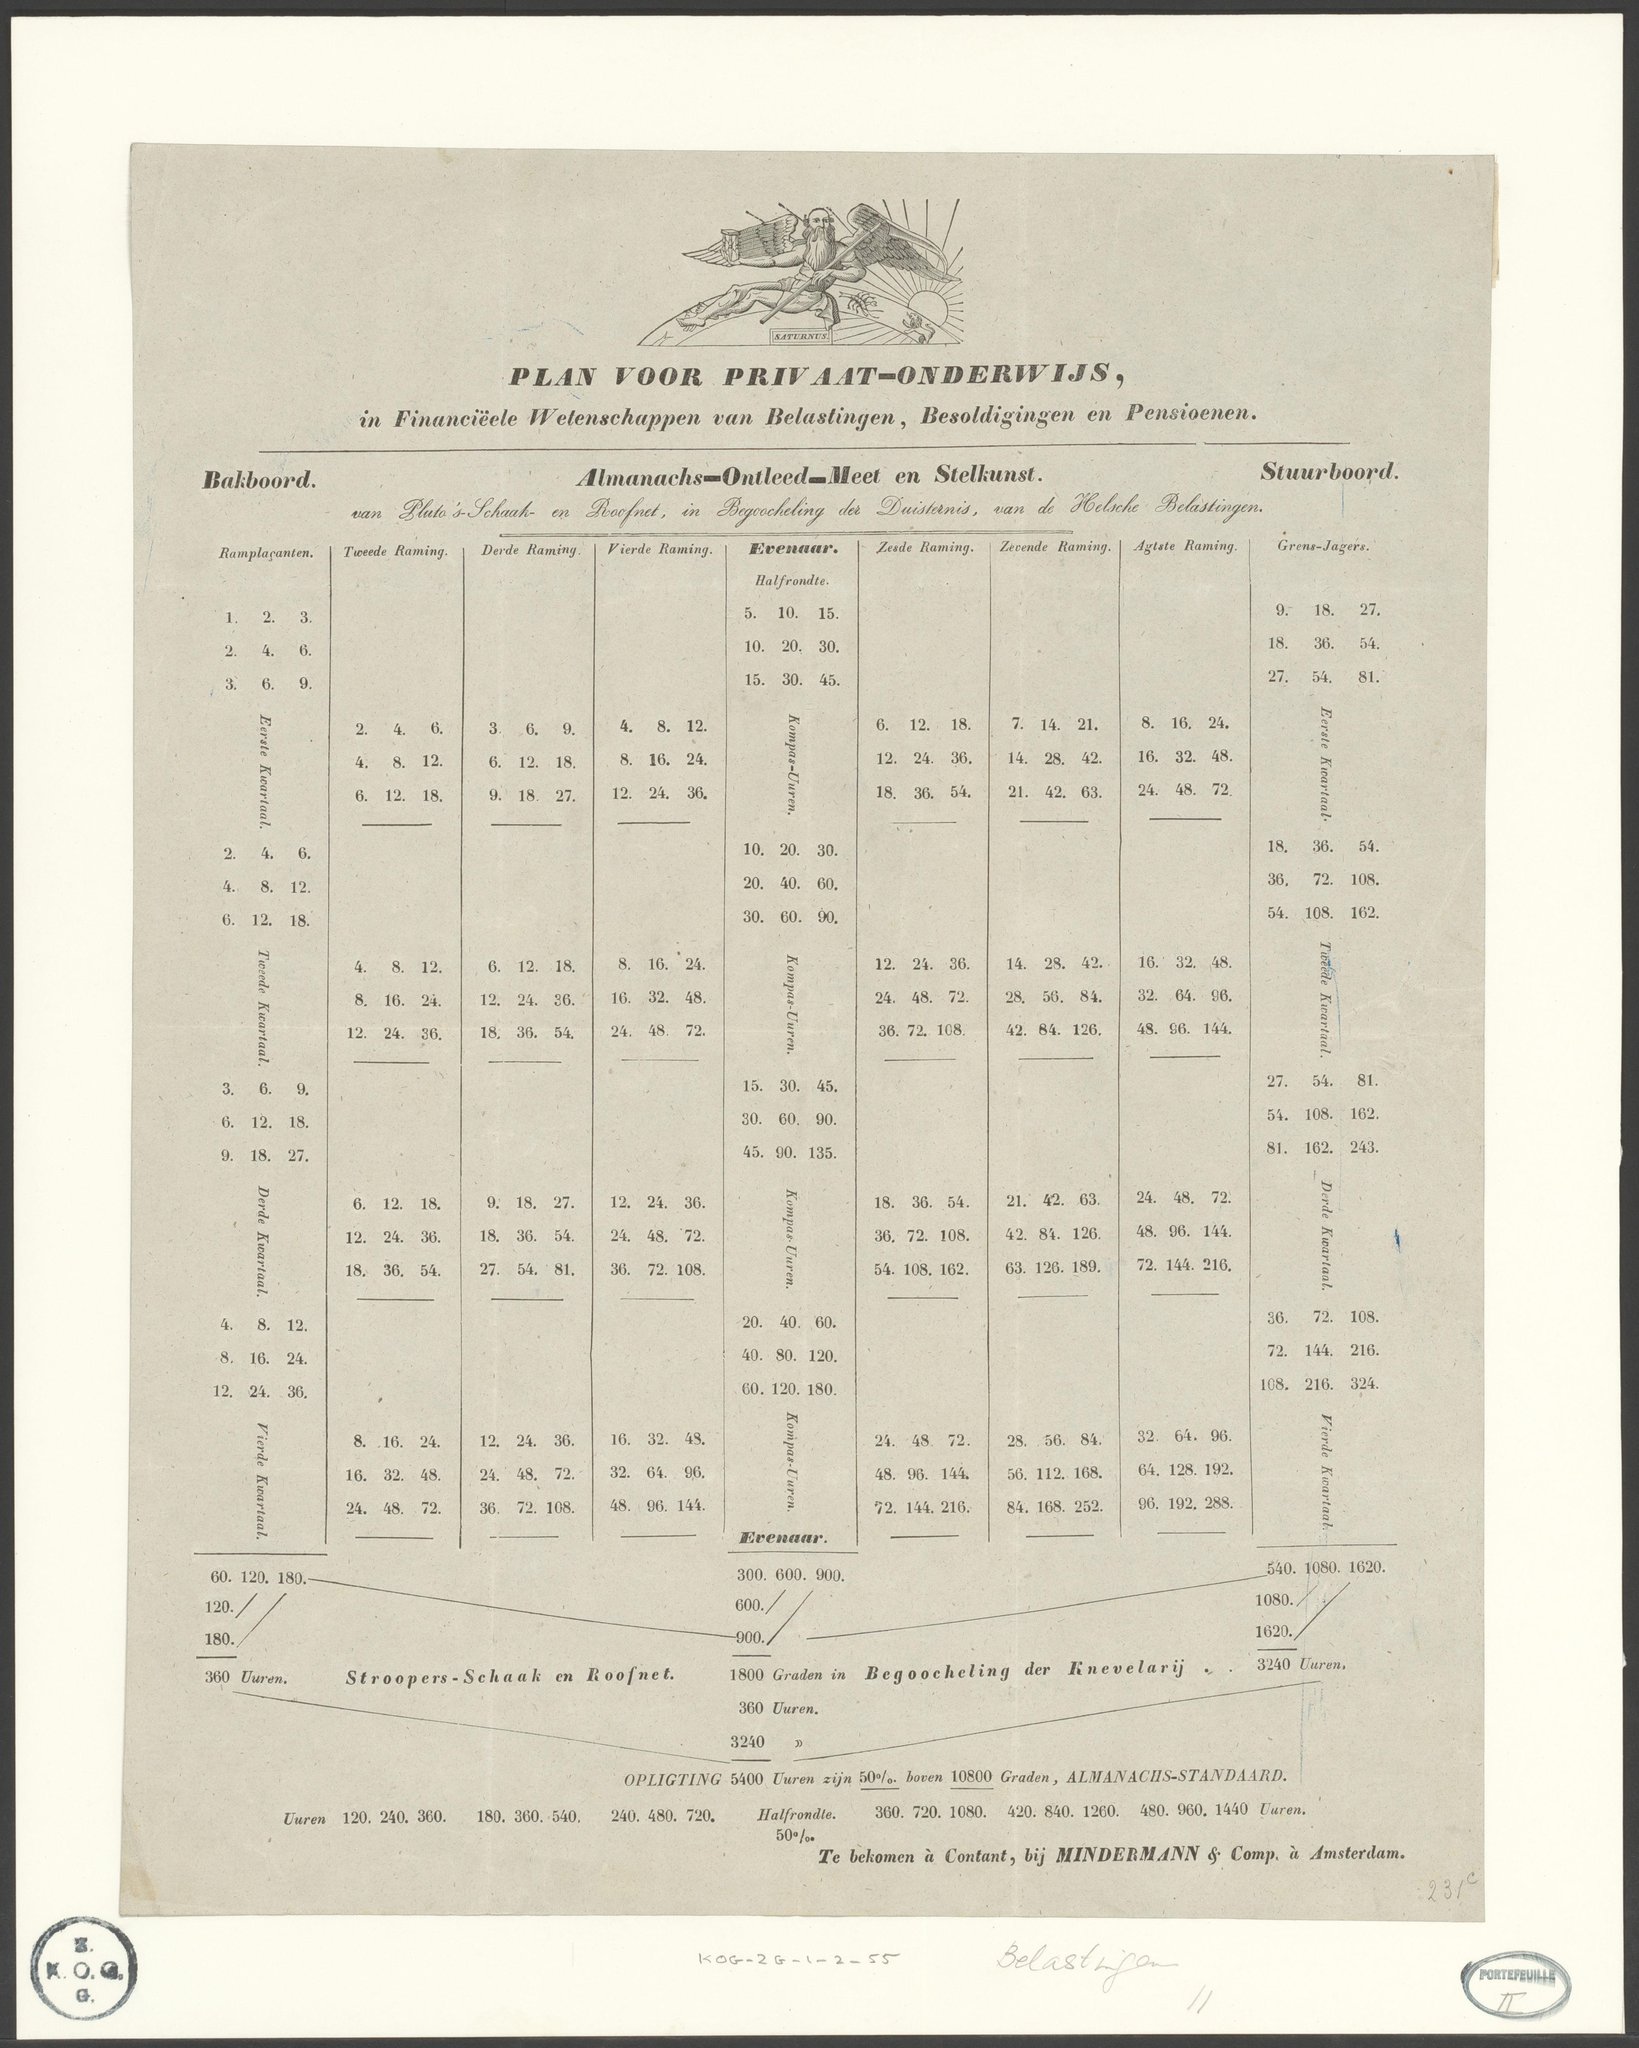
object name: text sheet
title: Plan voor Privaat-Onderwijs, in Financiëele Wetenschappen van Belastingen, Besoldigingen en Pensioenen / Almanachs-Ontleed-Meet en Stelkunst, van Pluto's Schaak- en Roofnet, in Begoocheling der Duisternis, van de Helsche Belastingen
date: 1815-1850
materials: paper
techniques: letterpress printing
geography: amsterdam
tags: tax collection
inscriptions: collector's mark, collector's mark: Lugt 1641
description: Spotprent op de belastingen. Blad met onzinnige tabellen en berekeningen. Bovenaan een vignet met Saturnus. Onderwerpsrubrieken binnen de Atlas Zeden en Gewoonten: Regeering, Belasting.